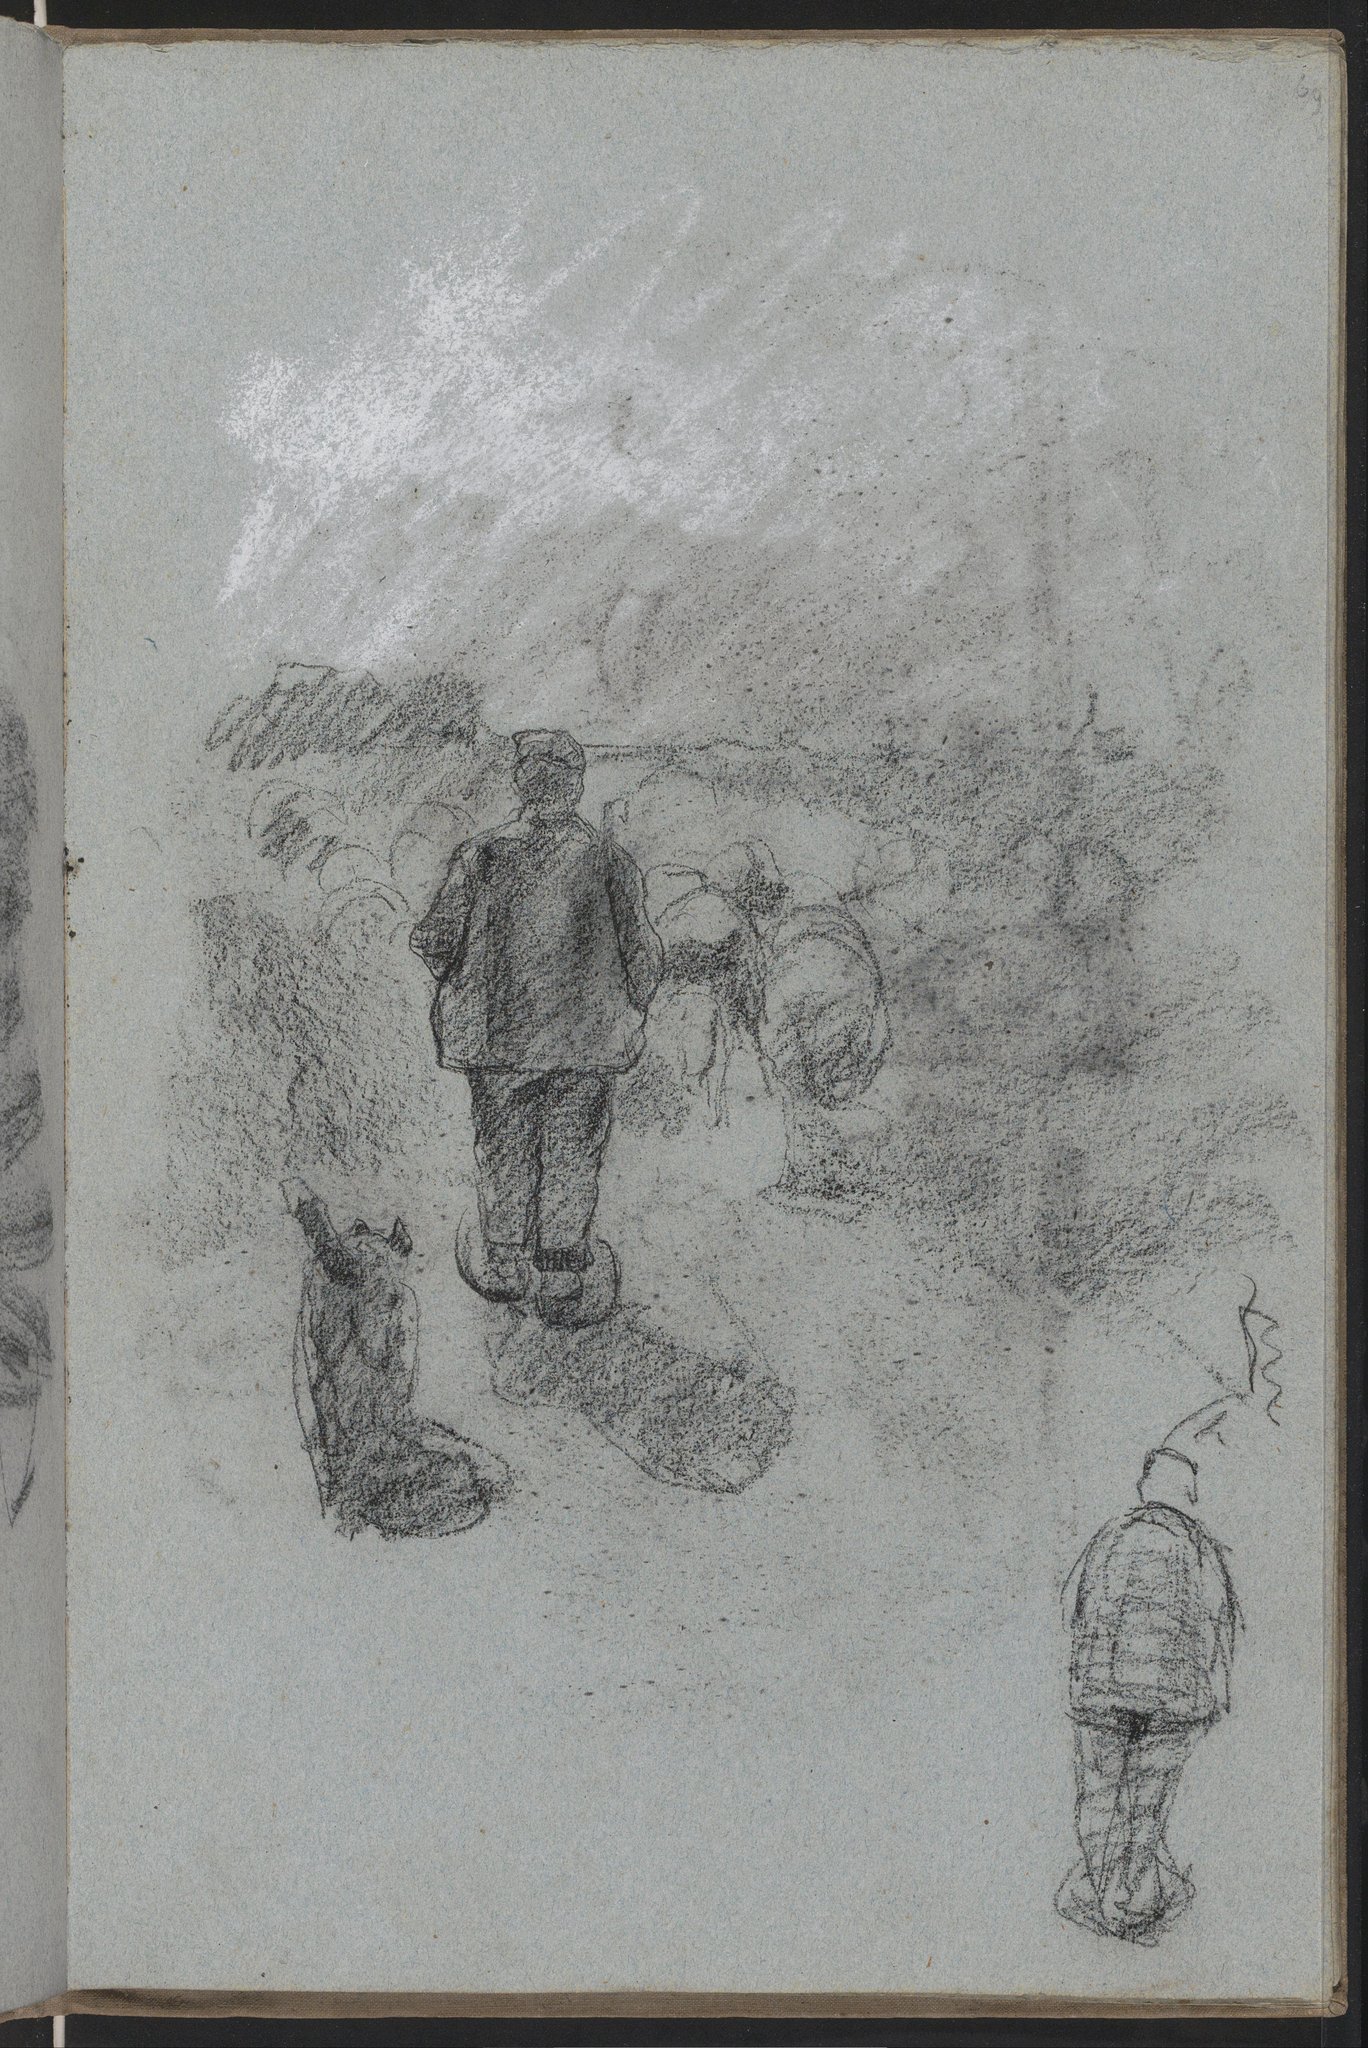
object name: sketchbook leaf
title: Schaapherder met hond achter zijn kudde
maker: willem witsen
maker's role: draughtsman, painter, print maker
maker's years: 1860-1923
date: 1884-1887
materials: chalk, paper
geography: ewijkshoeve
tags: landscapes in the temperate zone, cattle driving, cattle driver, sheep, dog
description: Pagina 69 uit een schetsboek met 45 bladen vervaardigd rond de Ewijkshoeve.